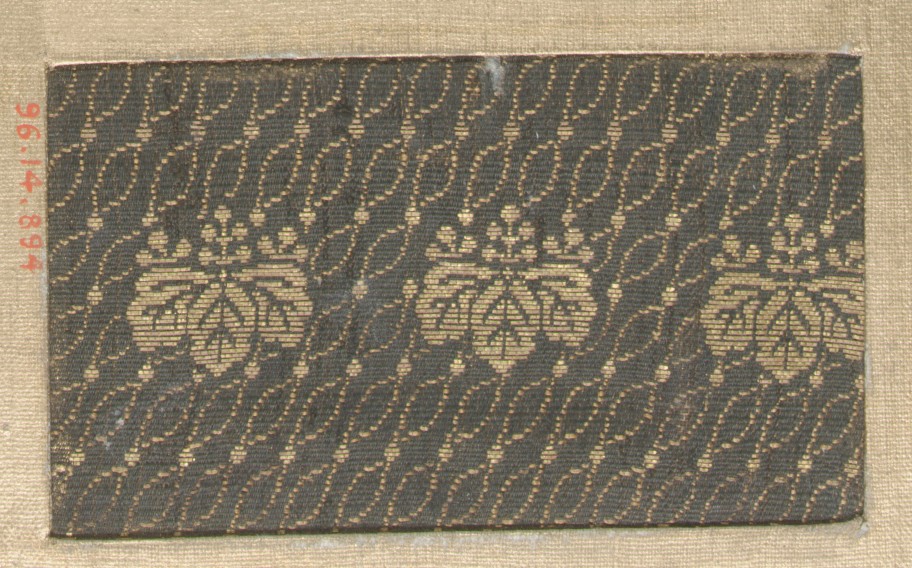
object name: piece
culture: japanese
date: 1701-1900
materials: silk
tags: leaves